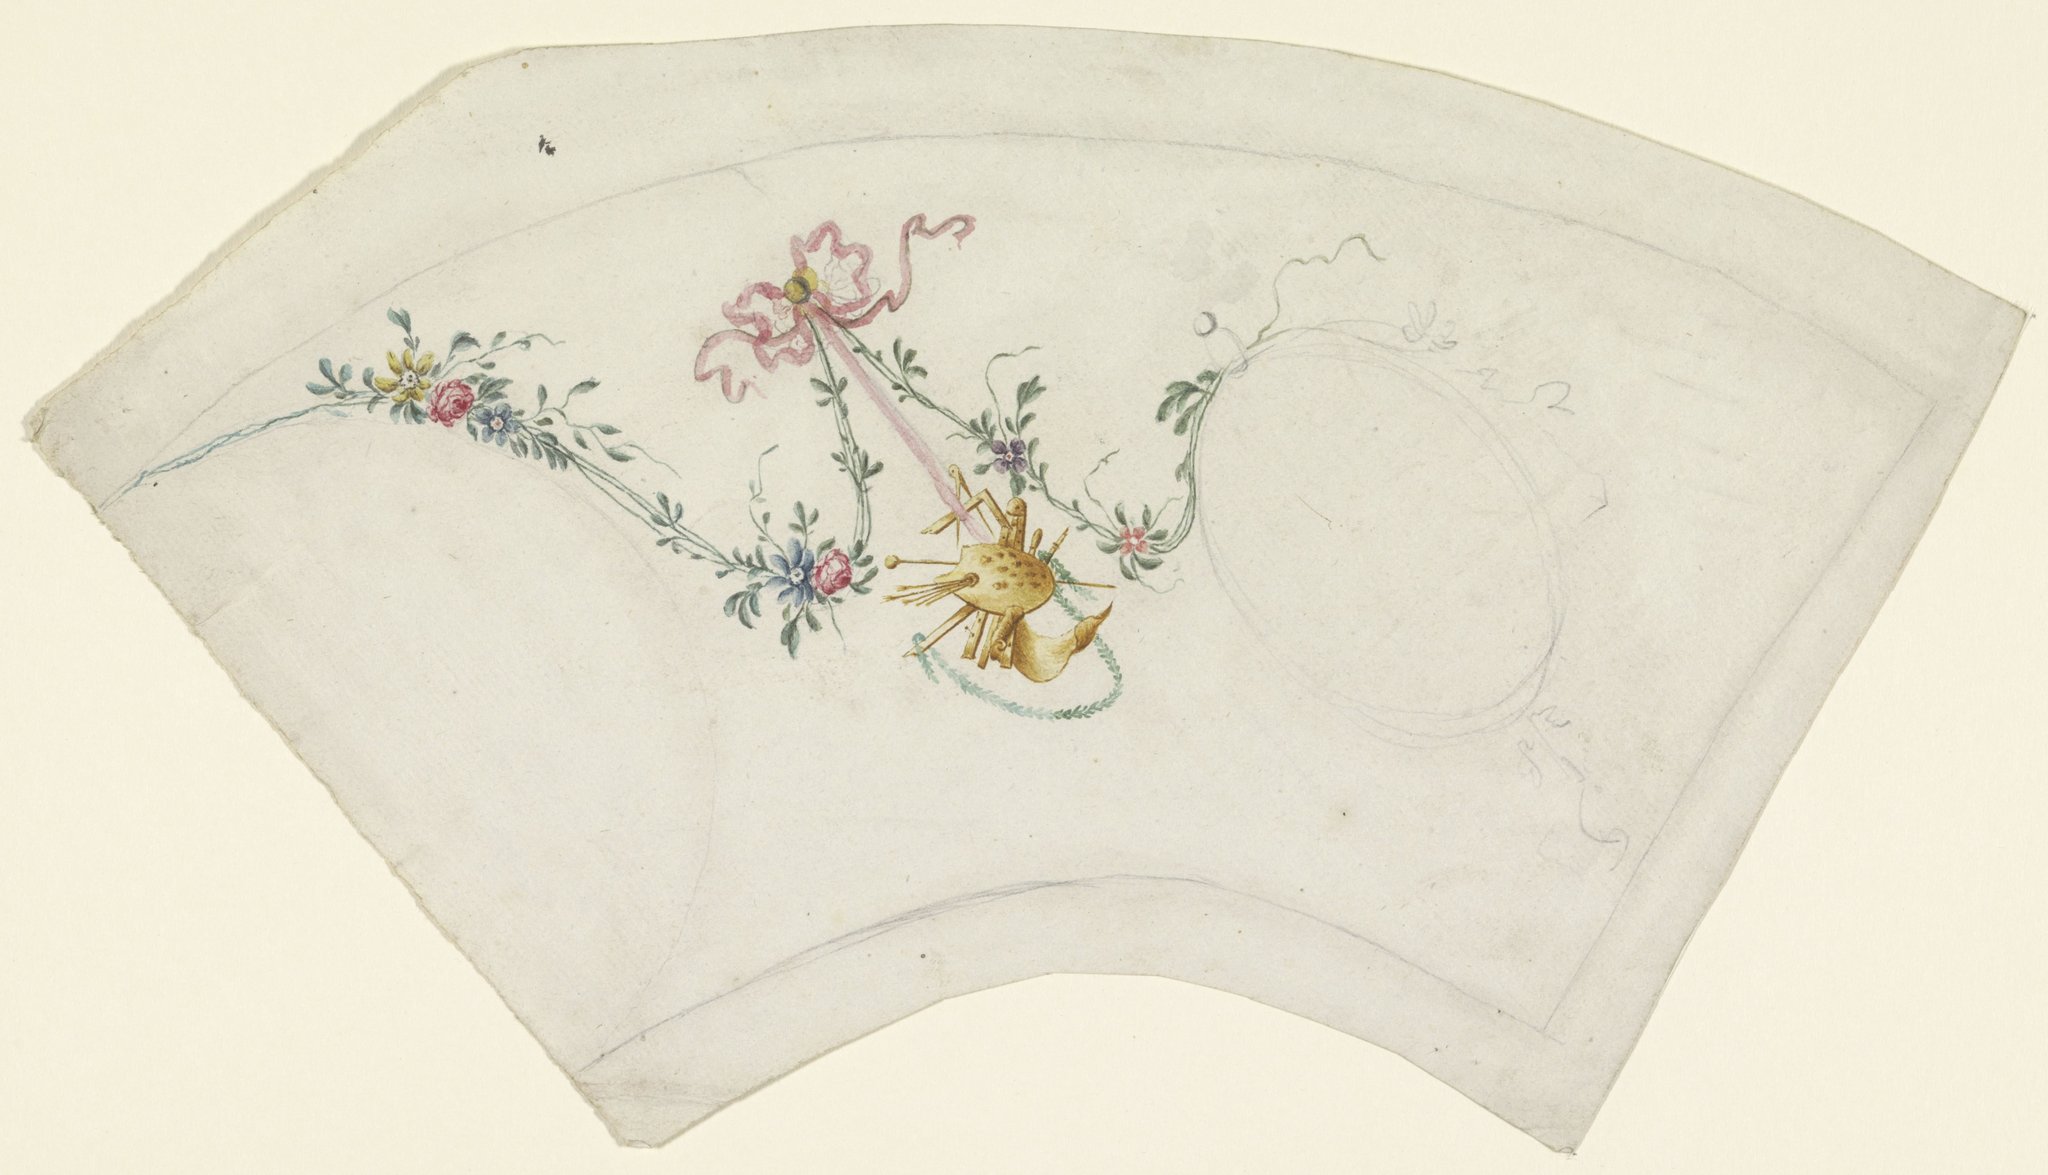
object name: drawing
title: Guirlande en trofee met schildersattributen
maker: Anonymous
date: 1600-1800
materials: paper, pencil, watercolor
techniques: brush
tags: trophy, i.e.: decorative arrangement of symbolic or typical objects ~ ornament, tools, implements of painter, ornament ~ festoon, garland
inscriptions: collector's mark: Lugt 2228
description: Een waaierblad met medaillons, een bloemenguirlande en een trofee met schilderattributen.